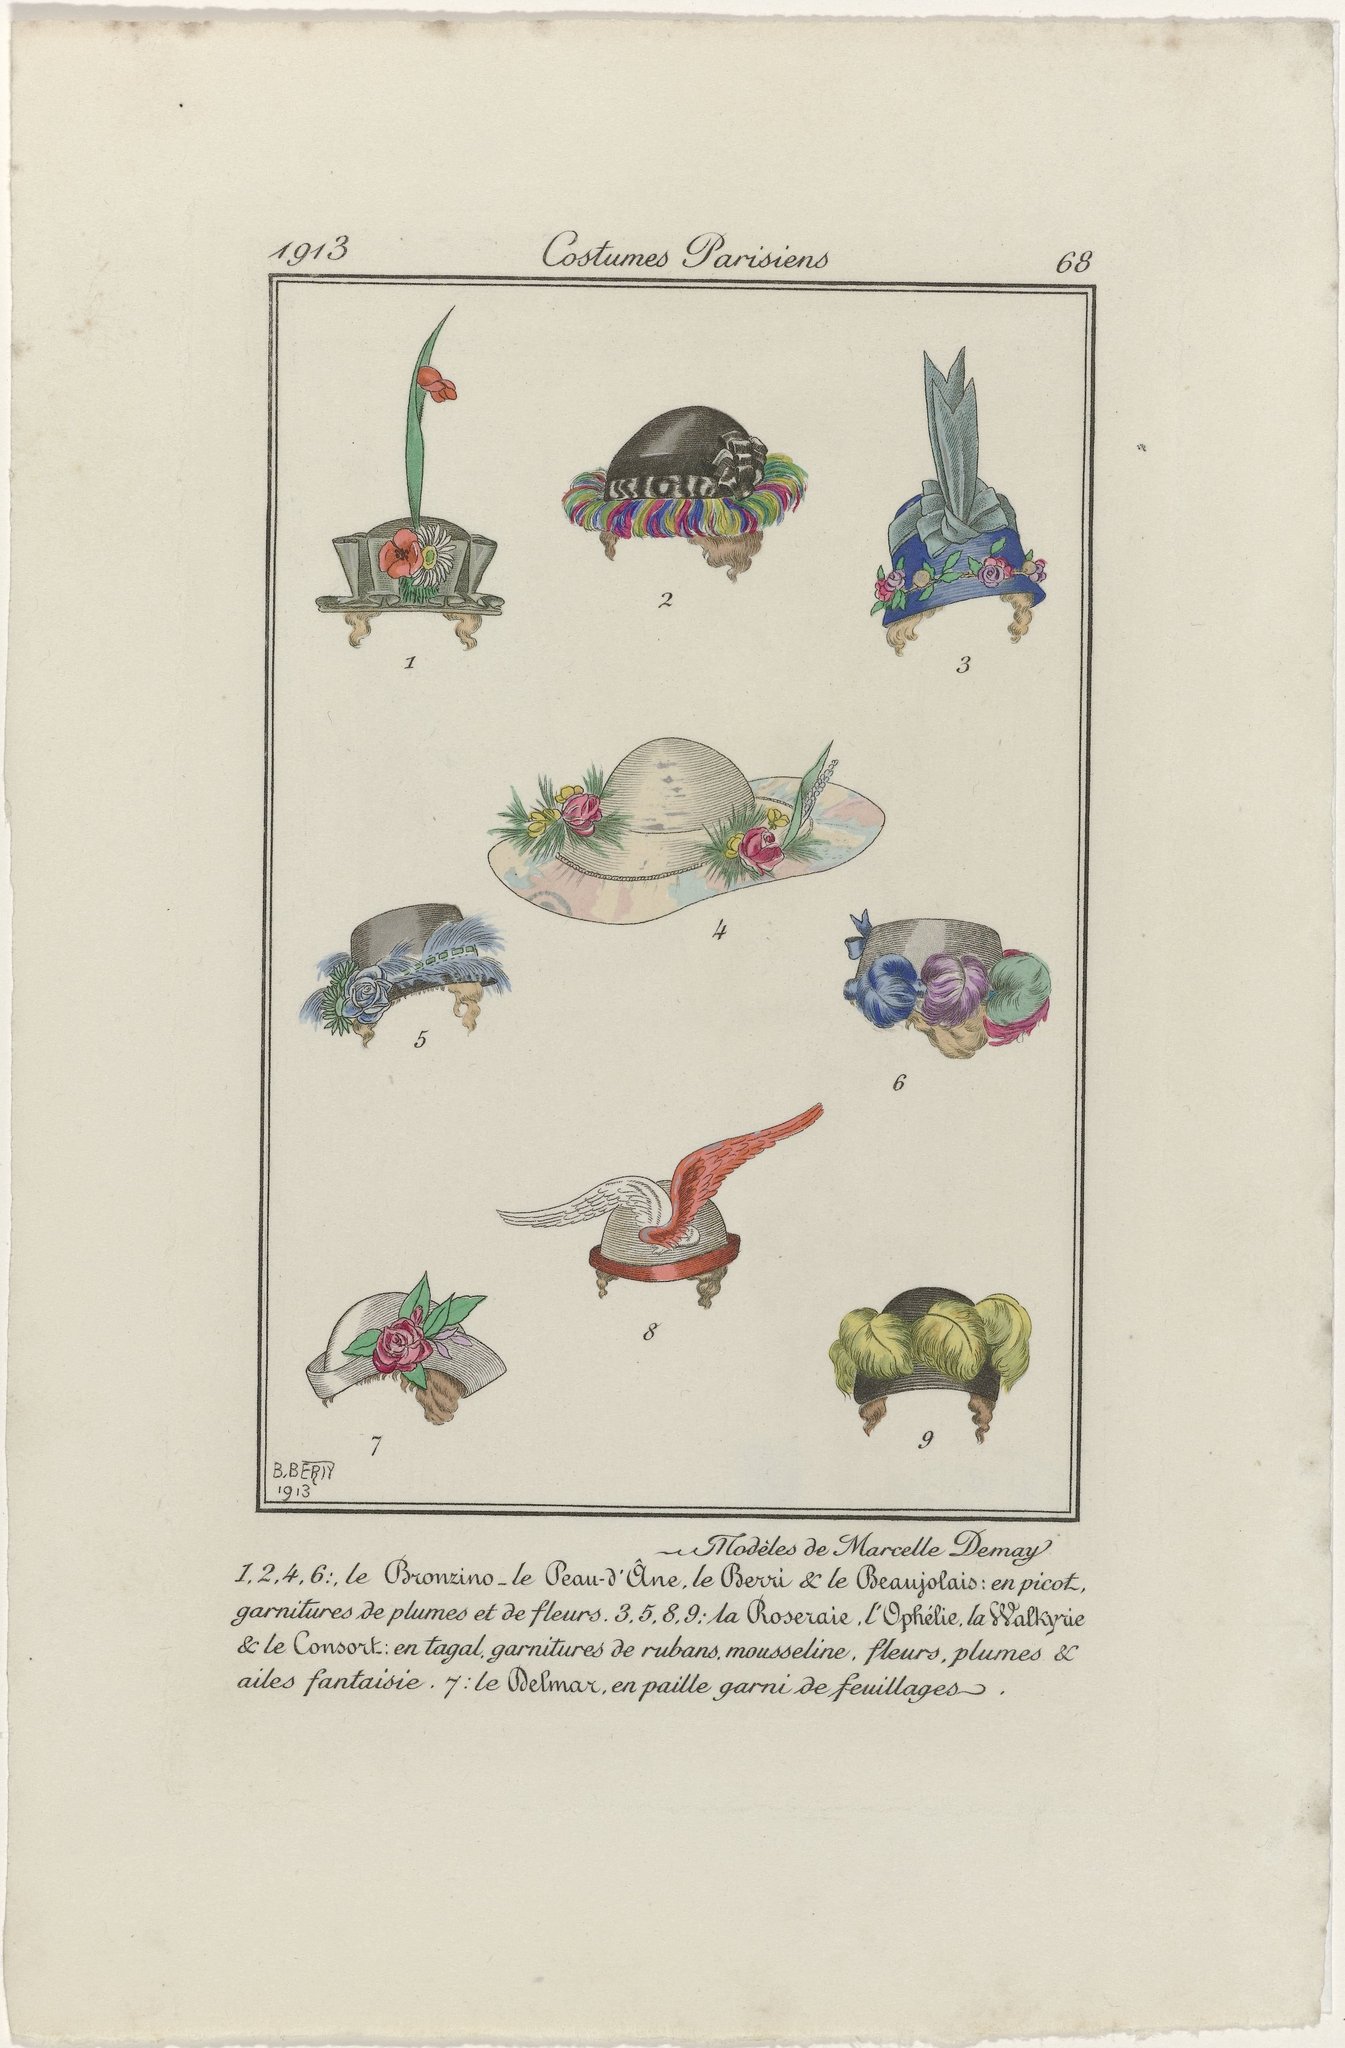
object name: fashion print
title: Accessories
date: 1913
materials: paper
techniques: engraving, hand coloring, pochoir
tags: flowers, border, ribbon, braid (+ women's clothes), fashion plates, head-gear: hat (+ women's clothes), head-gear: hat (+ feathers used for clothes)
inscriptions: title: ‘Costumes Parisiens’, caption: ‘Modèles de Marcelle Demay. 1,2,4,6:, le Bronzino_le Peau-d'Âne, le Berri & le Beaujolais : en picot, garnitures de plumes et de fleurs.3,5,8,9: La Roseraie.l'Ophélie,la Walkyrie & le Consort: en tagal, garnitures de rubans. mousseline, fleurs, plumes & ailes fantaisie.7: le Delmar, en paille garni de feuillages.’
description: Fans, parasols, opera gloves, fashionable hats, small toques garnished with feathers, wristwatches, compact bracelets, and luxuriously crafted lighters: there was a dazzling variety of accessories in the 1920s. Small bags could be suspended from a belt, or a glove. Walking sticks and the shafts of umbrellas and parasols were often embellished with carving clearly inspired by African and Indian art. And Russian influence was evident when it came to combs made of mother-of-pearl and ivory.